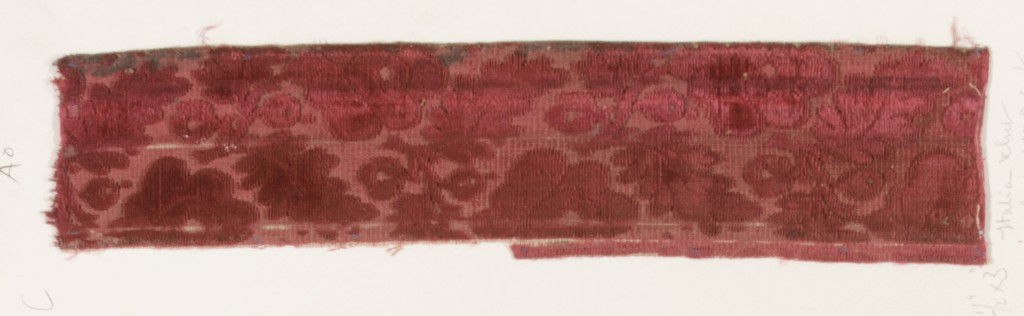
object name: fragment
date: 1501-1700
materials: silk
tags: leaves